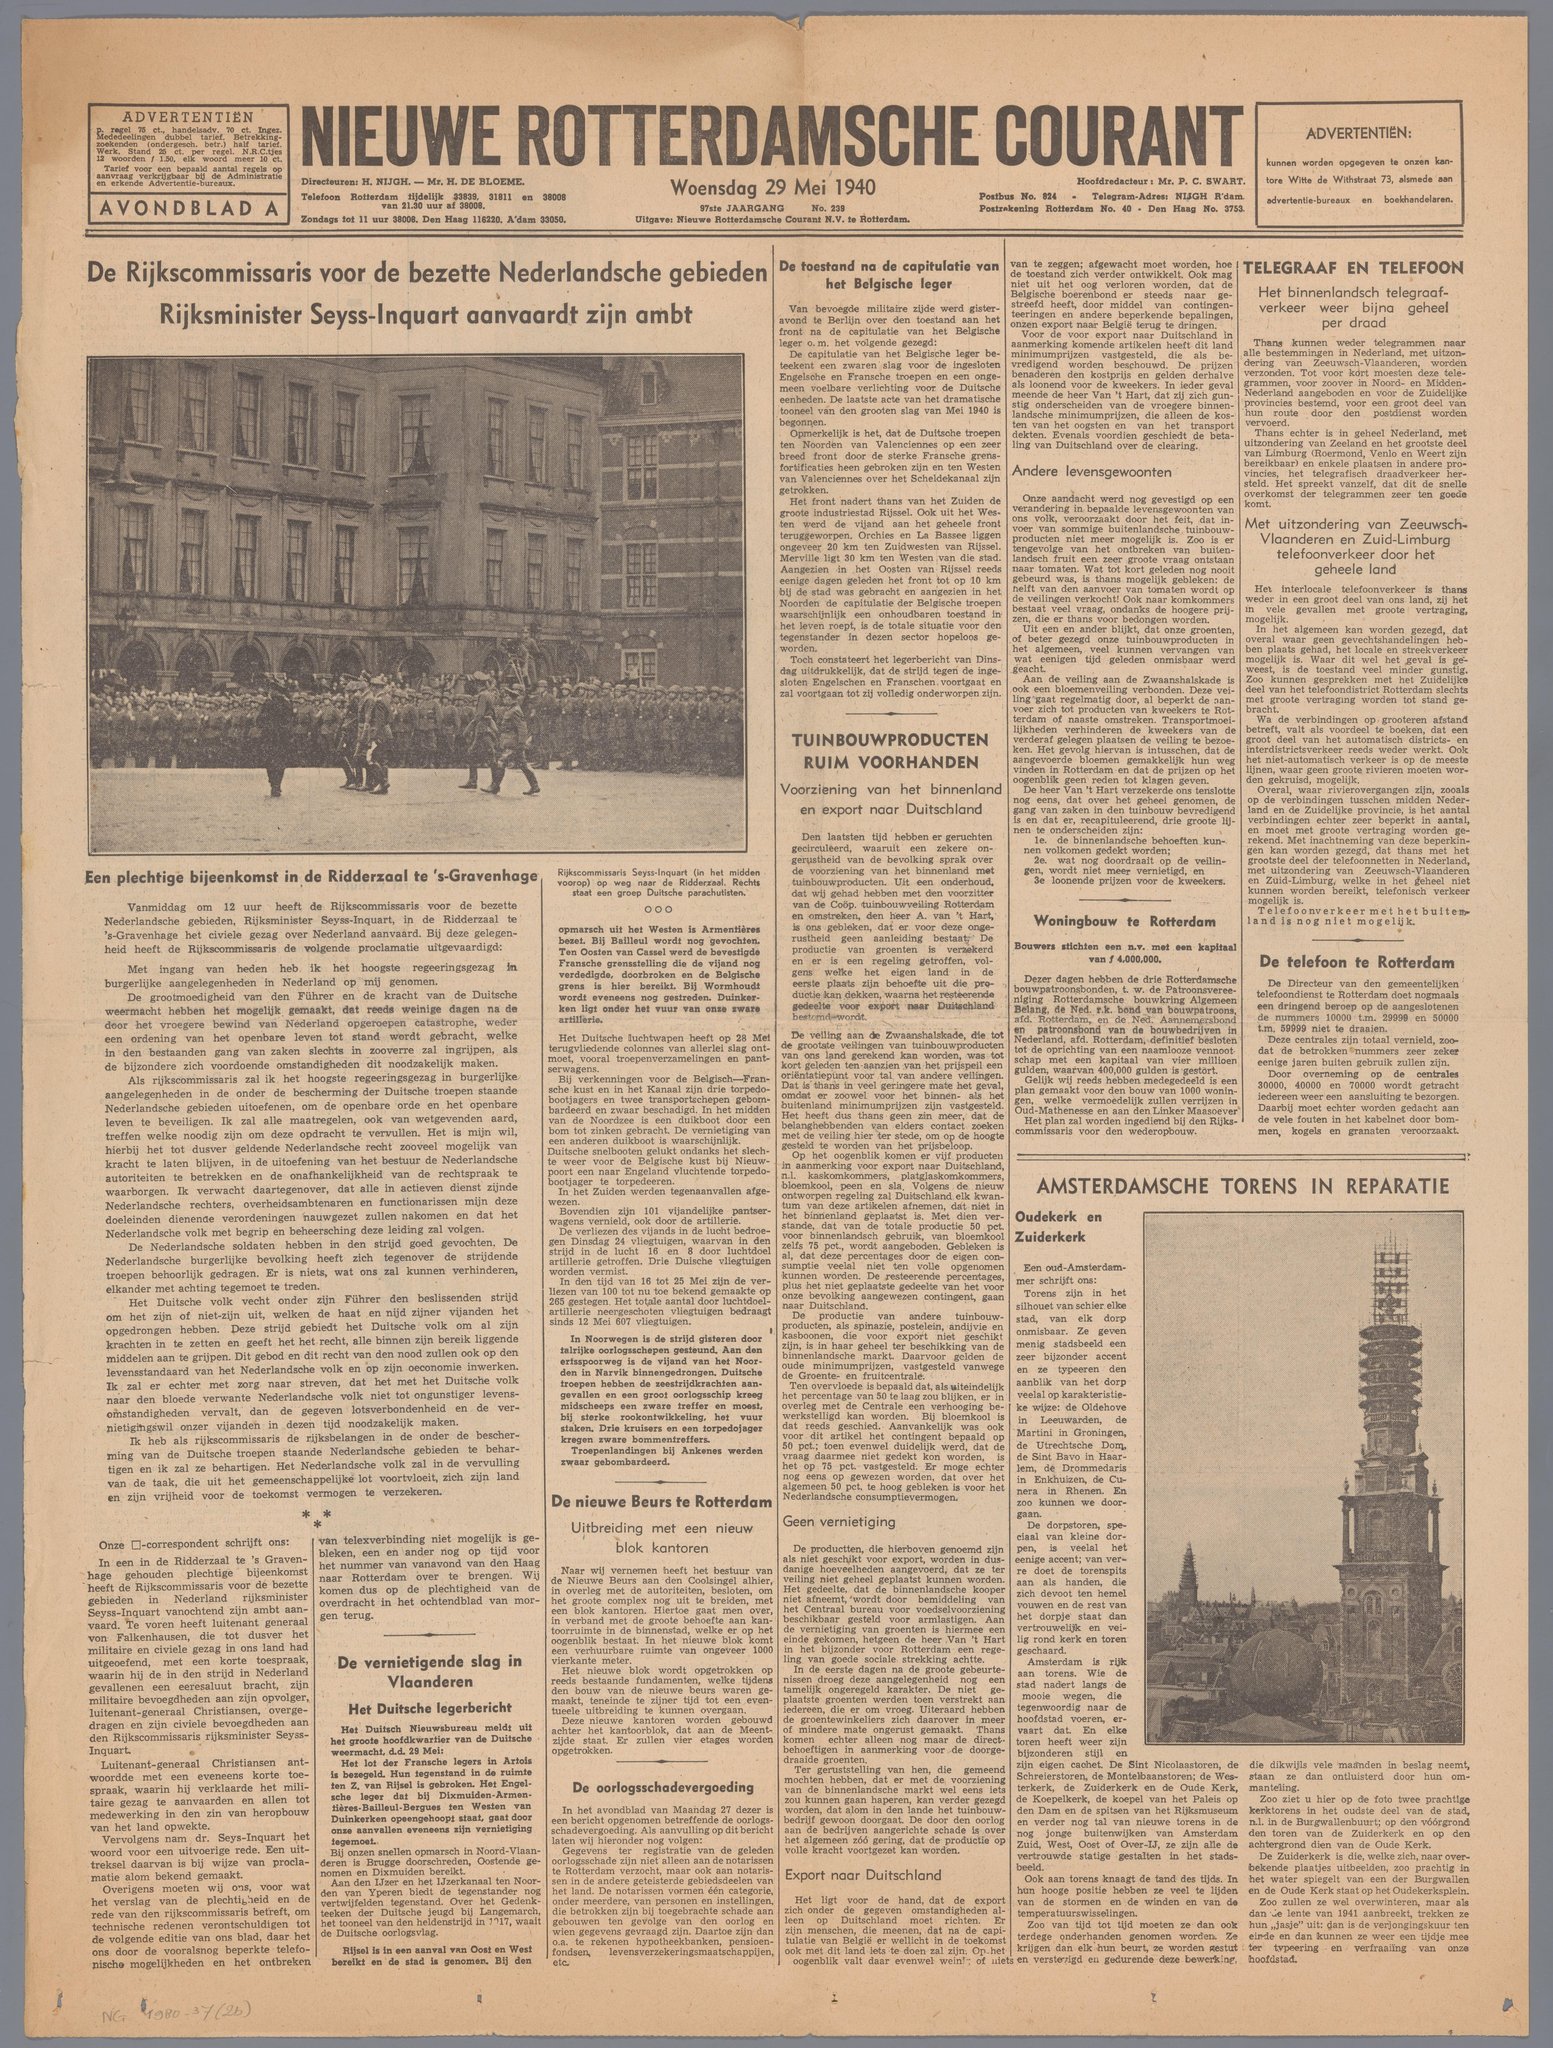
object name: newspaper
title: Nieuwe Rotterdamsche Courant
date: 1940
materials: paper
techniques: printing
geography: rotterdam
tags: netherlands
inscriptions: date